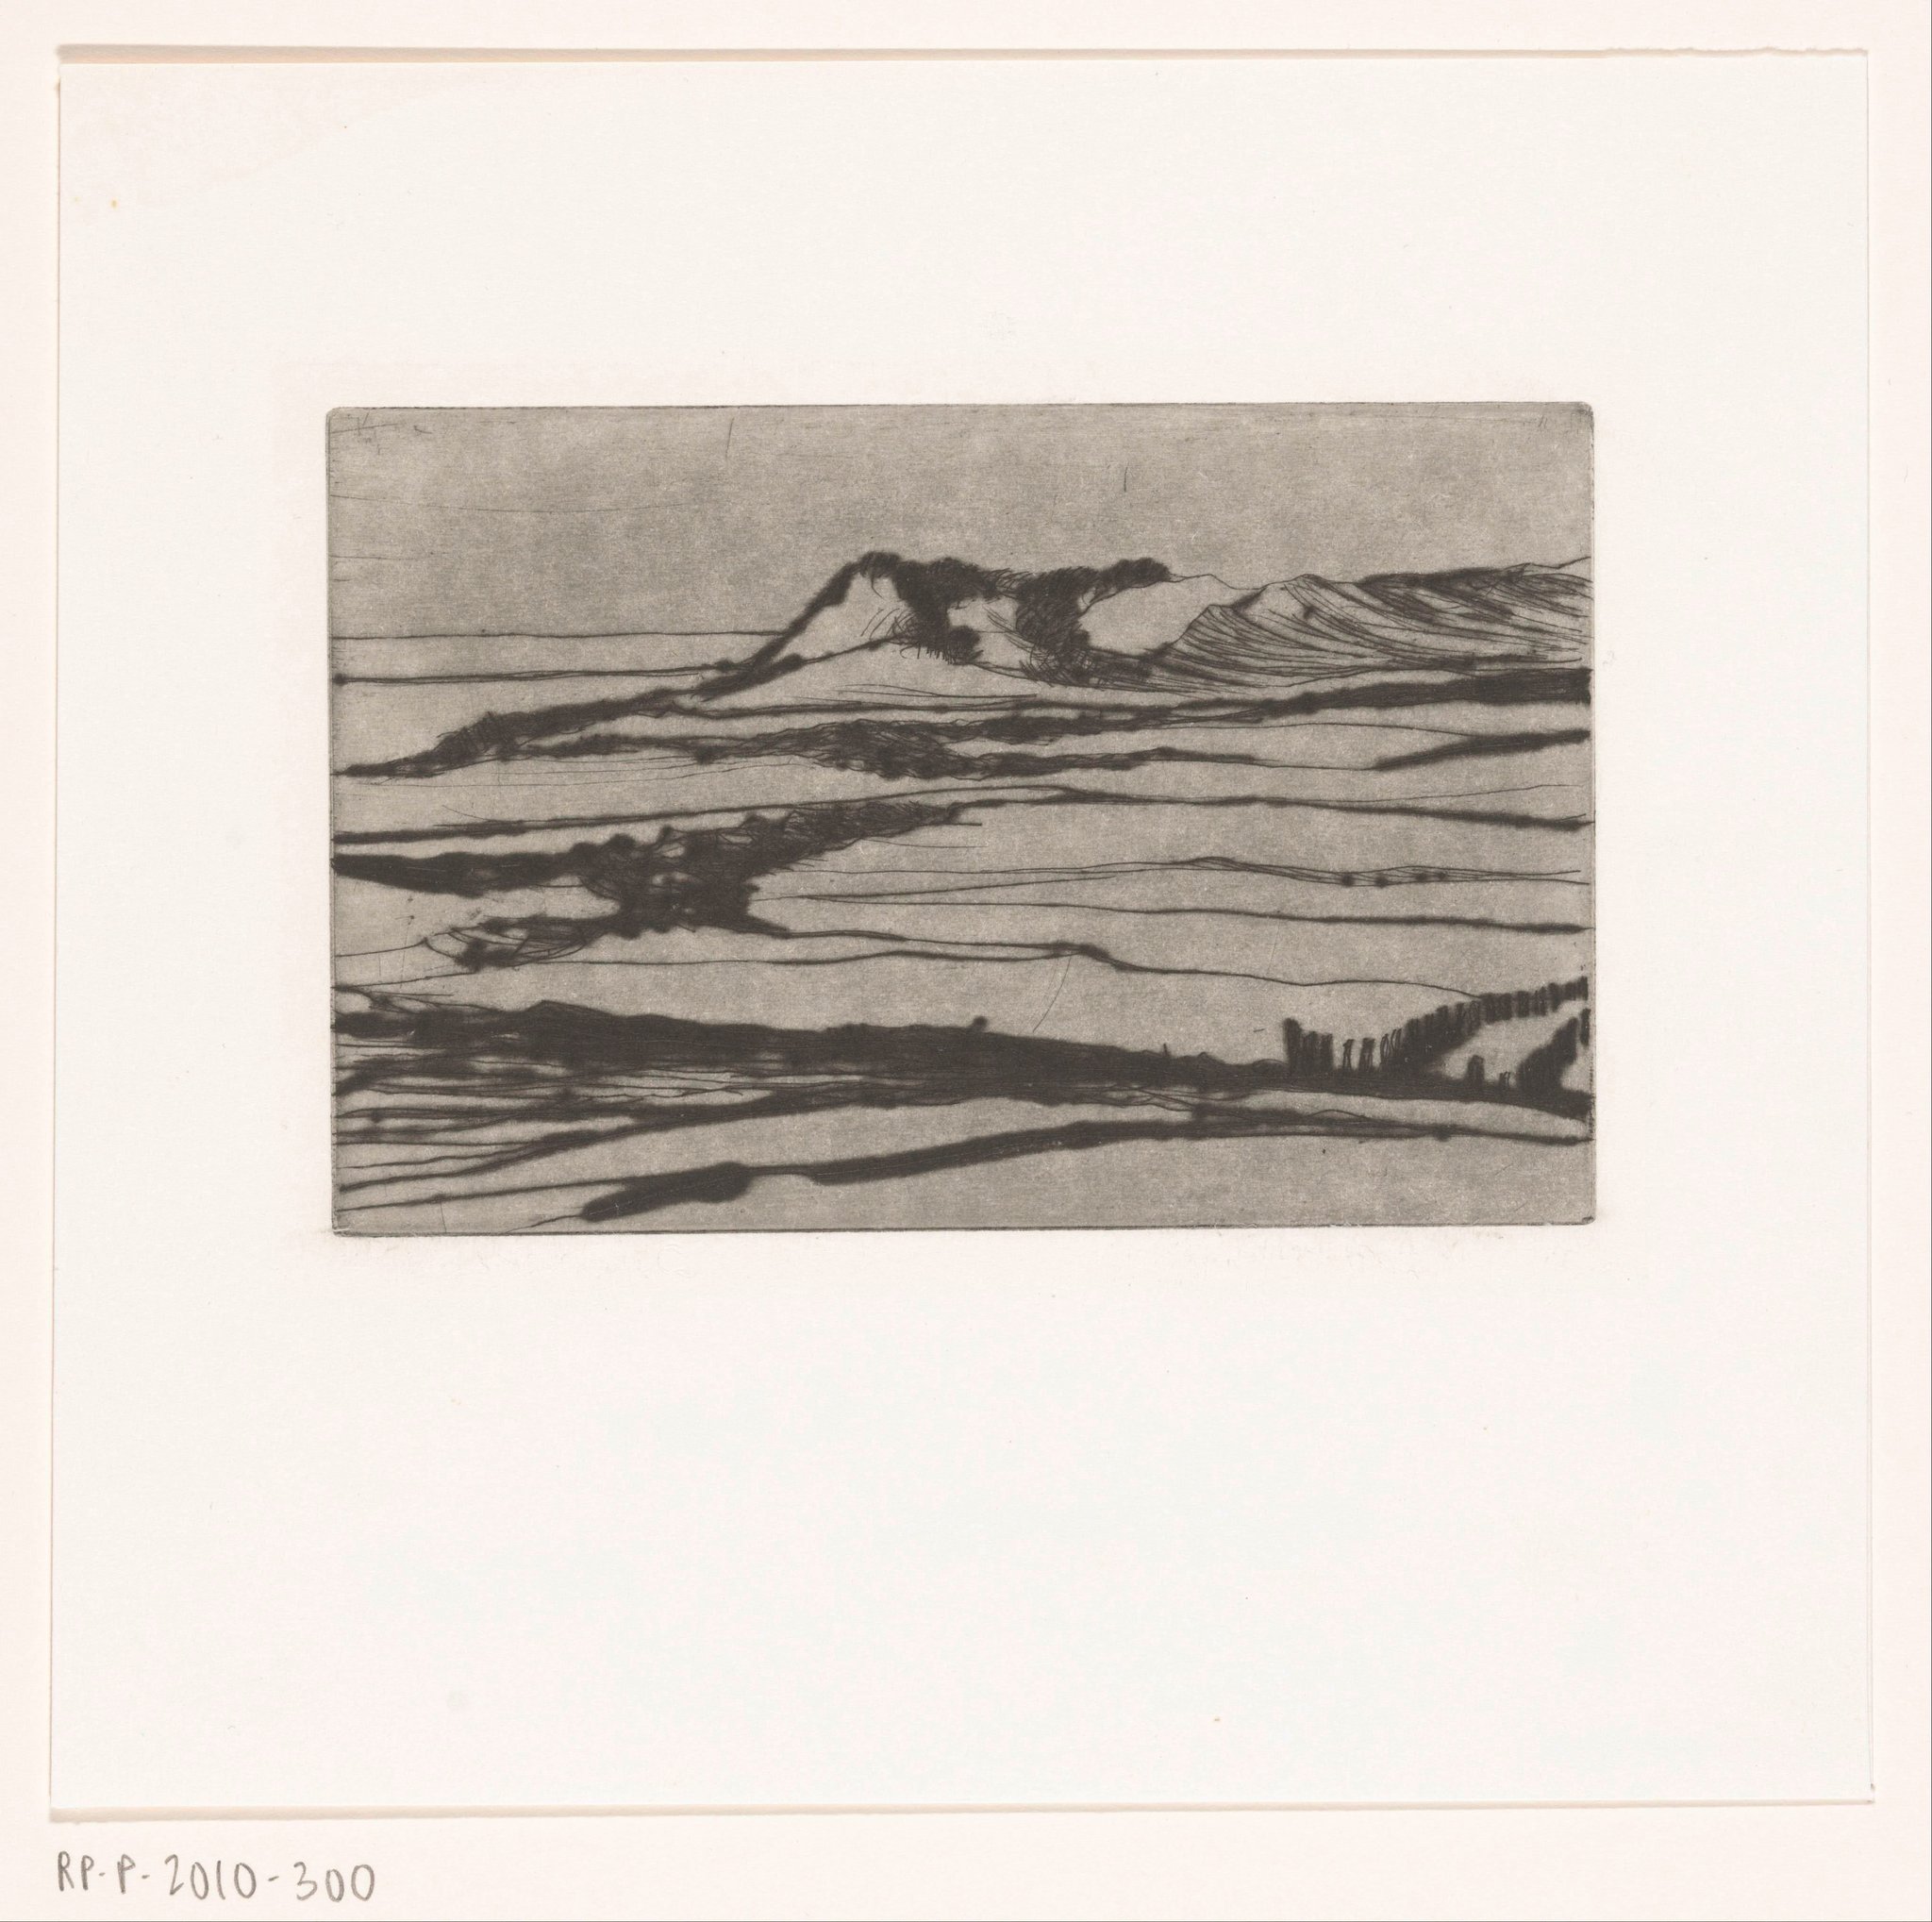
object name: print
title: 't Zwin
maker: ronald noorman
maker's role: draughtsman, print maker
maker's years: 1951-2018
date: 1908-1977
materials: paper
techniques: drypoint, intaglio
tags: dune coast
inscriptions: collector's mark: Lugt 2228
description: Natuurgebied Het Zwin, gezien vanuit de richting van Cadzand in Zeeuws-Vlaanderen. Op de achtergrond duinen.